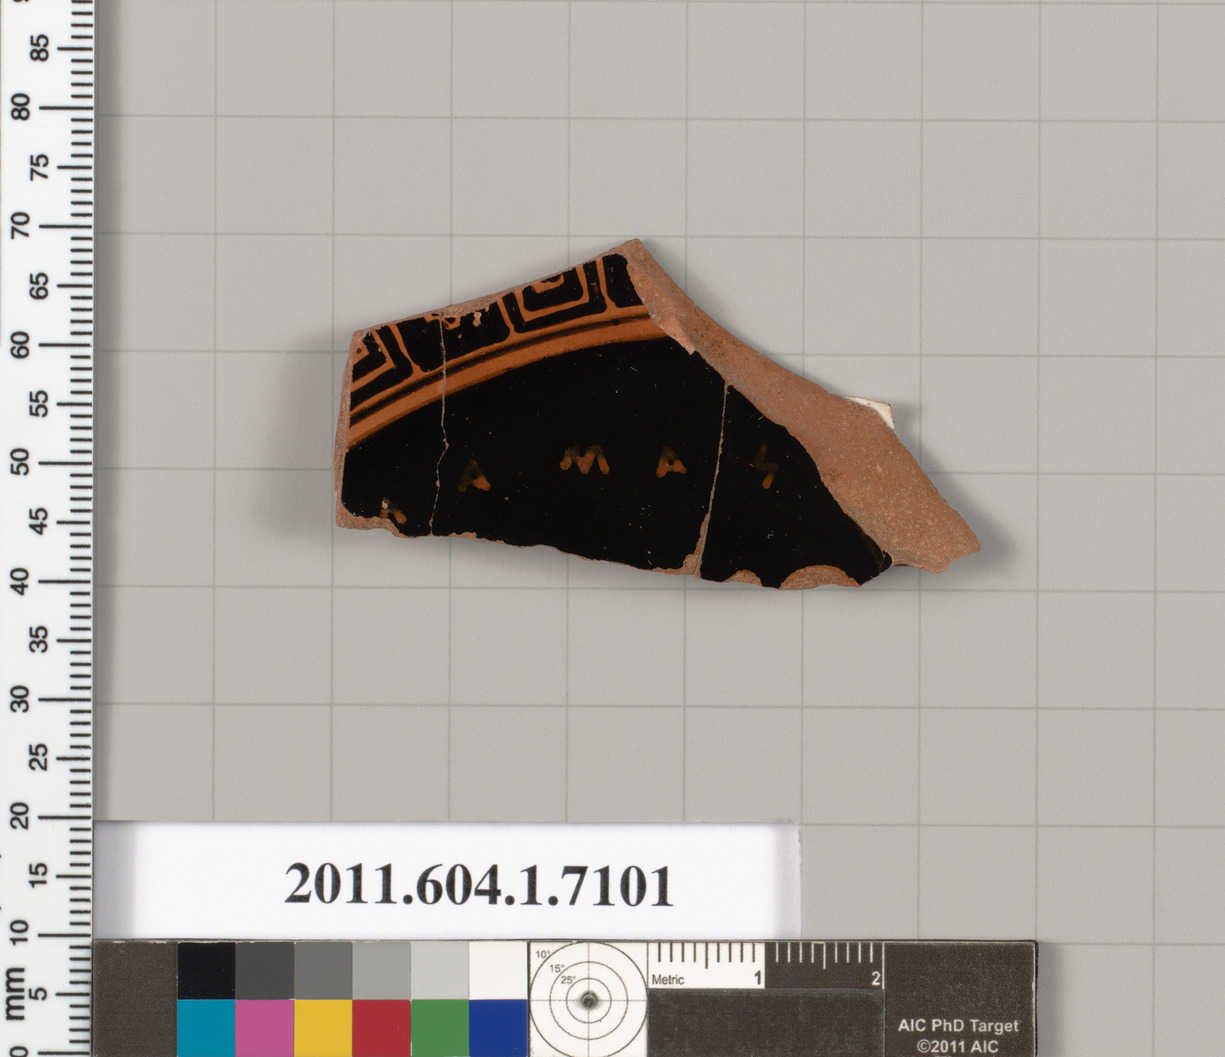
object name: kylix fragment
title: Terracotta fragment of a kylix (drinking cup)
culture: greek, attic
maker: douris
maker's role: artist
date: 500-480 BCE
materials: terracotta